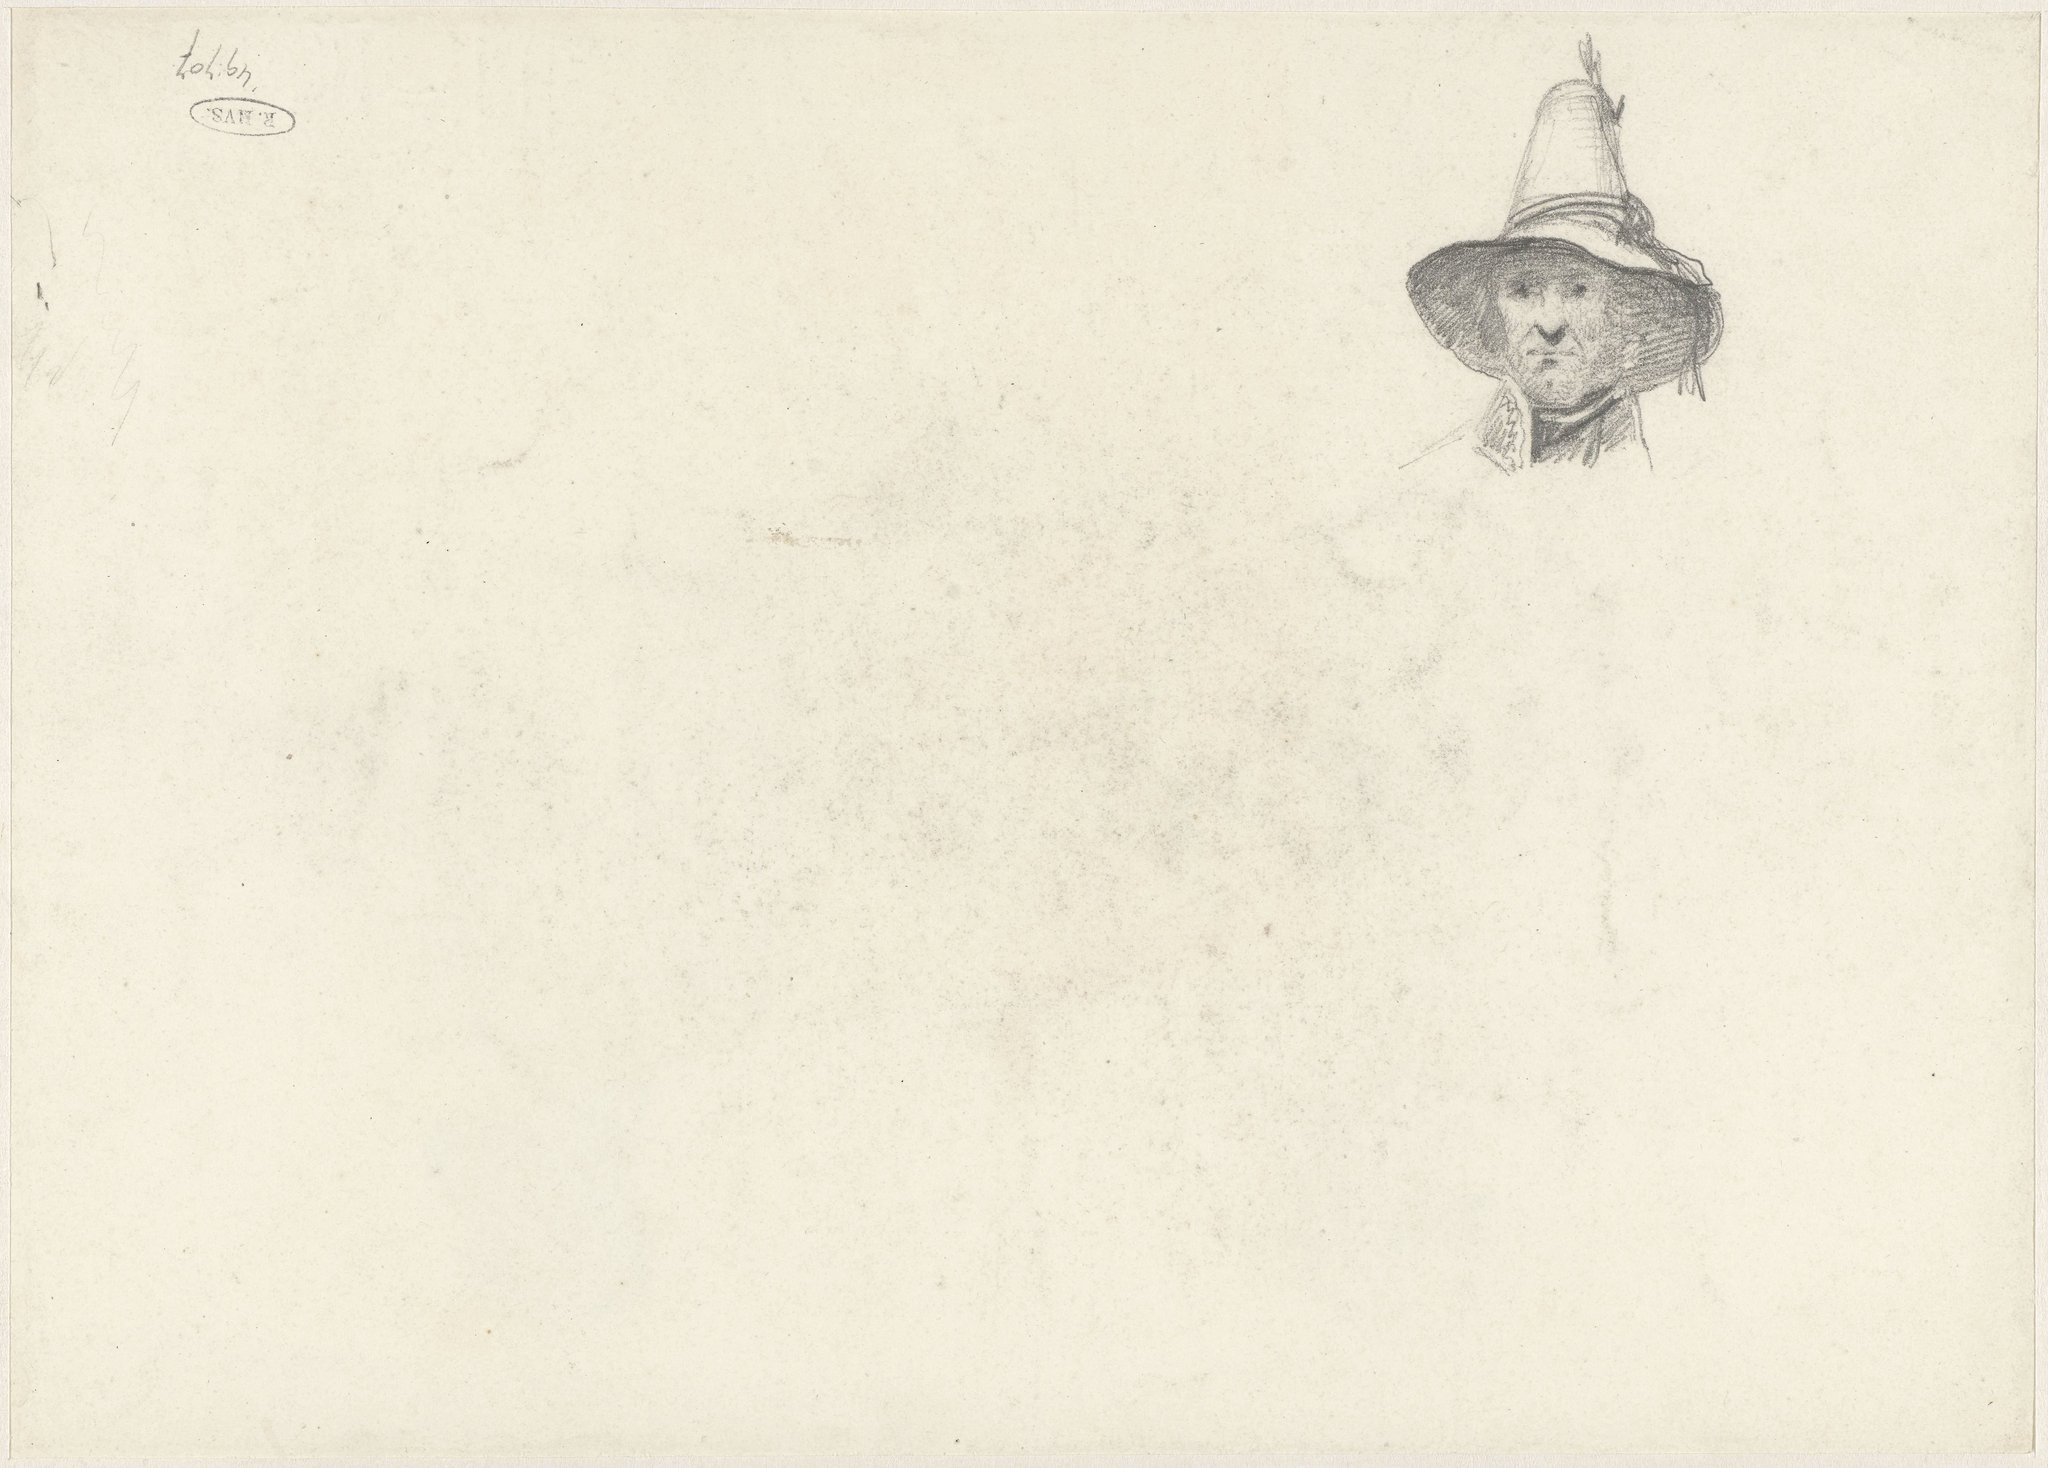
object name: drawing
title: Hoofd van een oude man met een punthoed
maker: guillaume anne van der brugghen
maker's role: draughtsman, print maker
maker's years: 1812-1891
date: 1821-1891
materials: paper, pencil